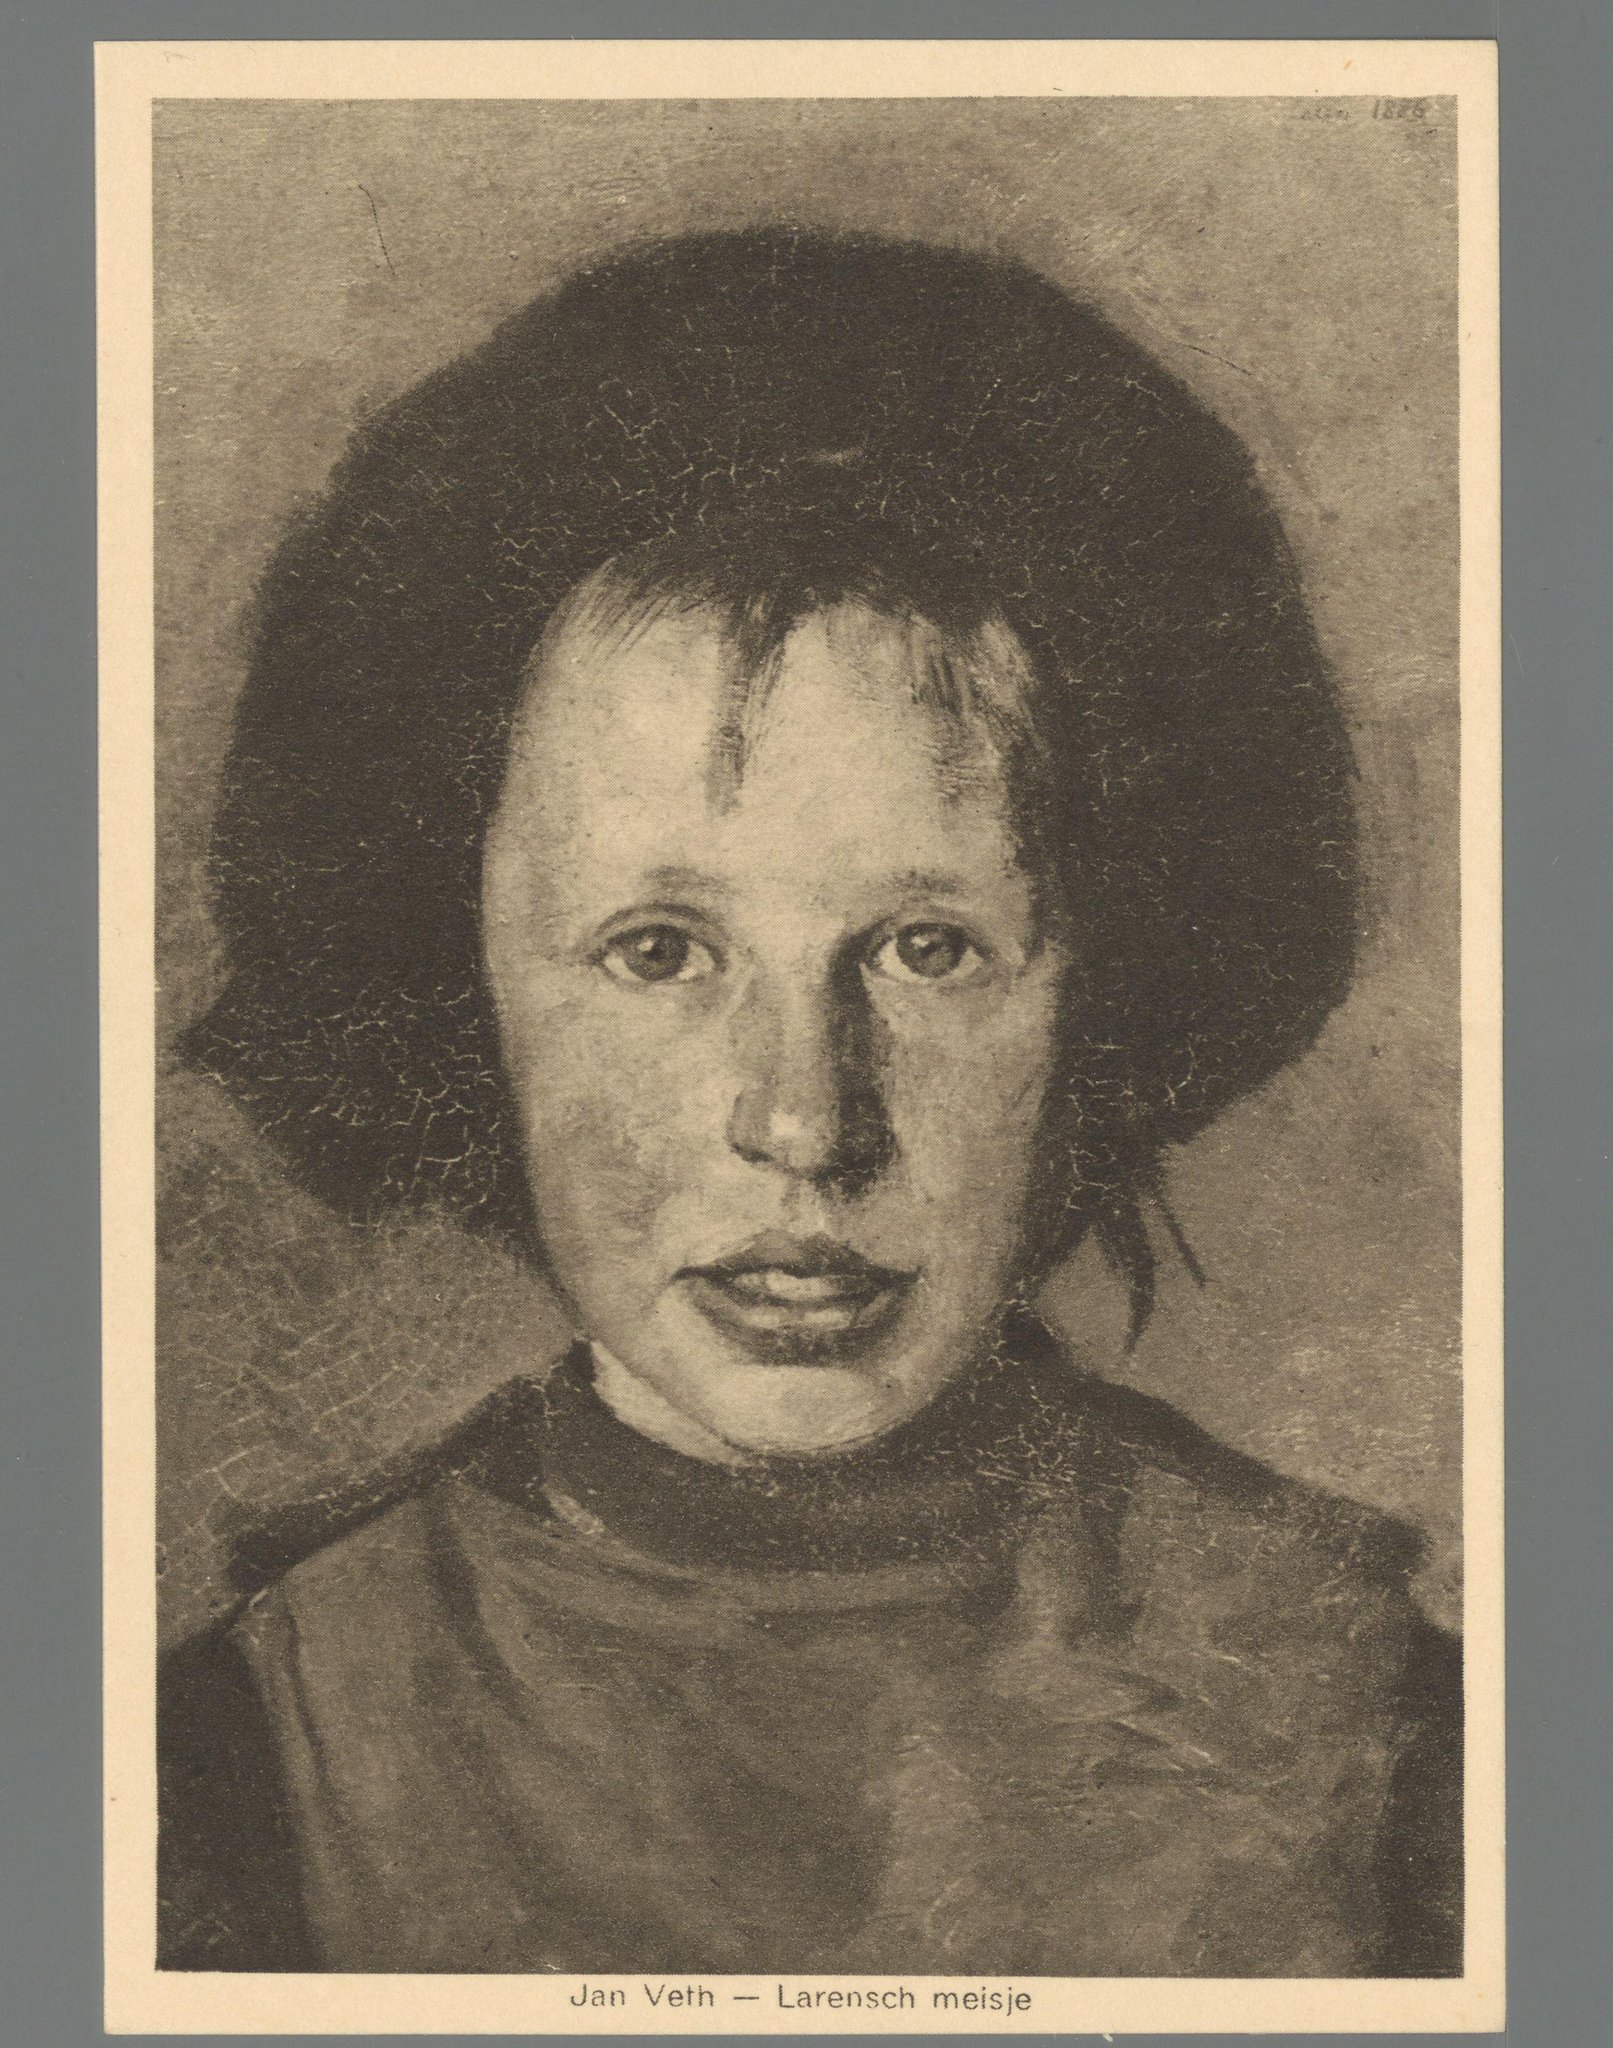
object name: ansichtkaart, prentbriefkaart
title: Jan Veth - Larensch meisje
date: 1928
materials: cardboard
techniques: rotogravure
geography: leiden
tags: adolescent, young woman, maiden, picture, painting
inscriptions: collector's mark: ‘AFE v S’